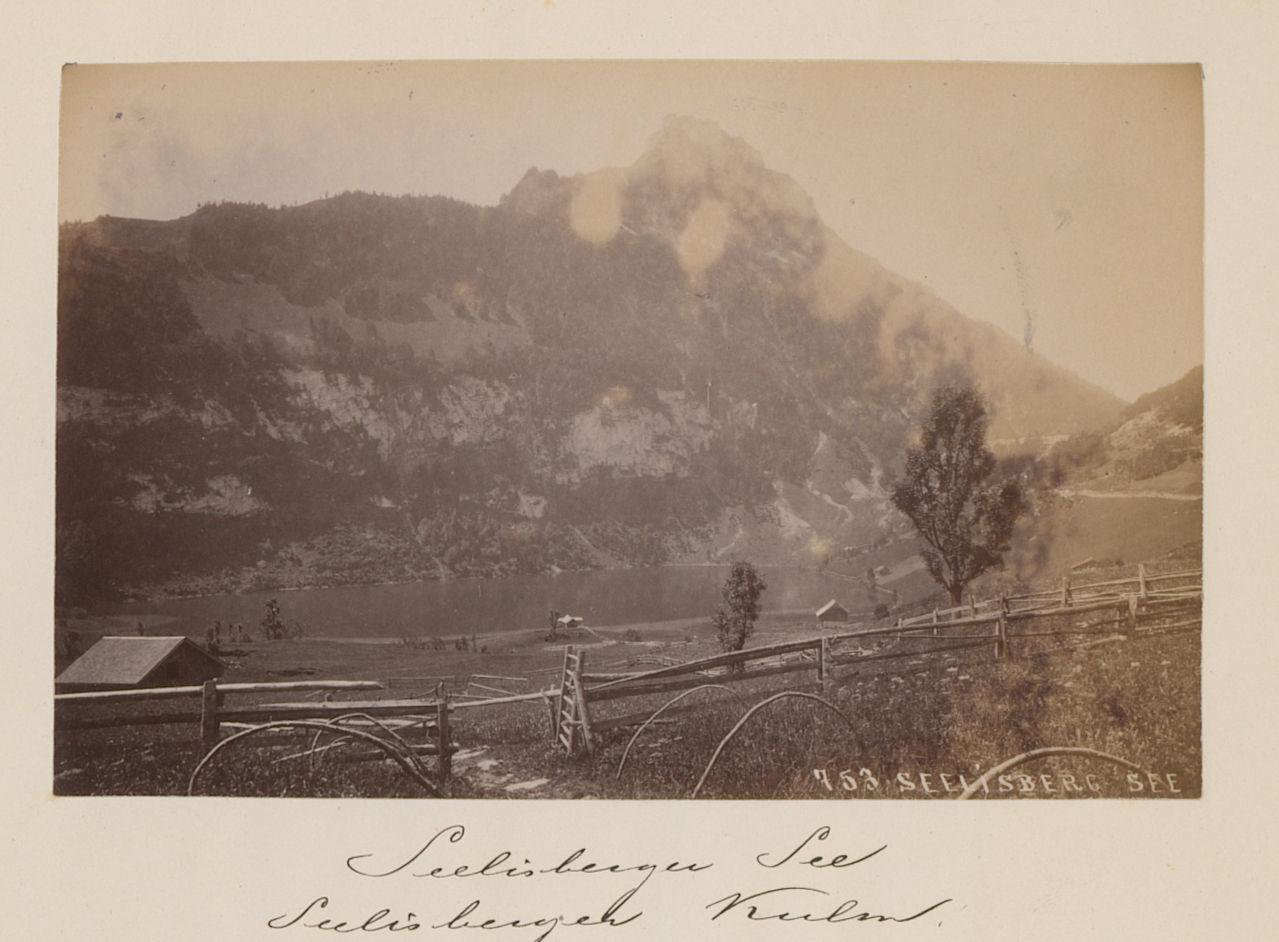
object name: photograph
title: Gezicht op het Seeli te Seelisberg, Zwitserland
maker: Anonymous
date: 1860-1900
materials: photographic support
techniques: albumen print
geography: seelisberg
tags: lake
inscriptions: inscription: ‘753, Seelisberg See’